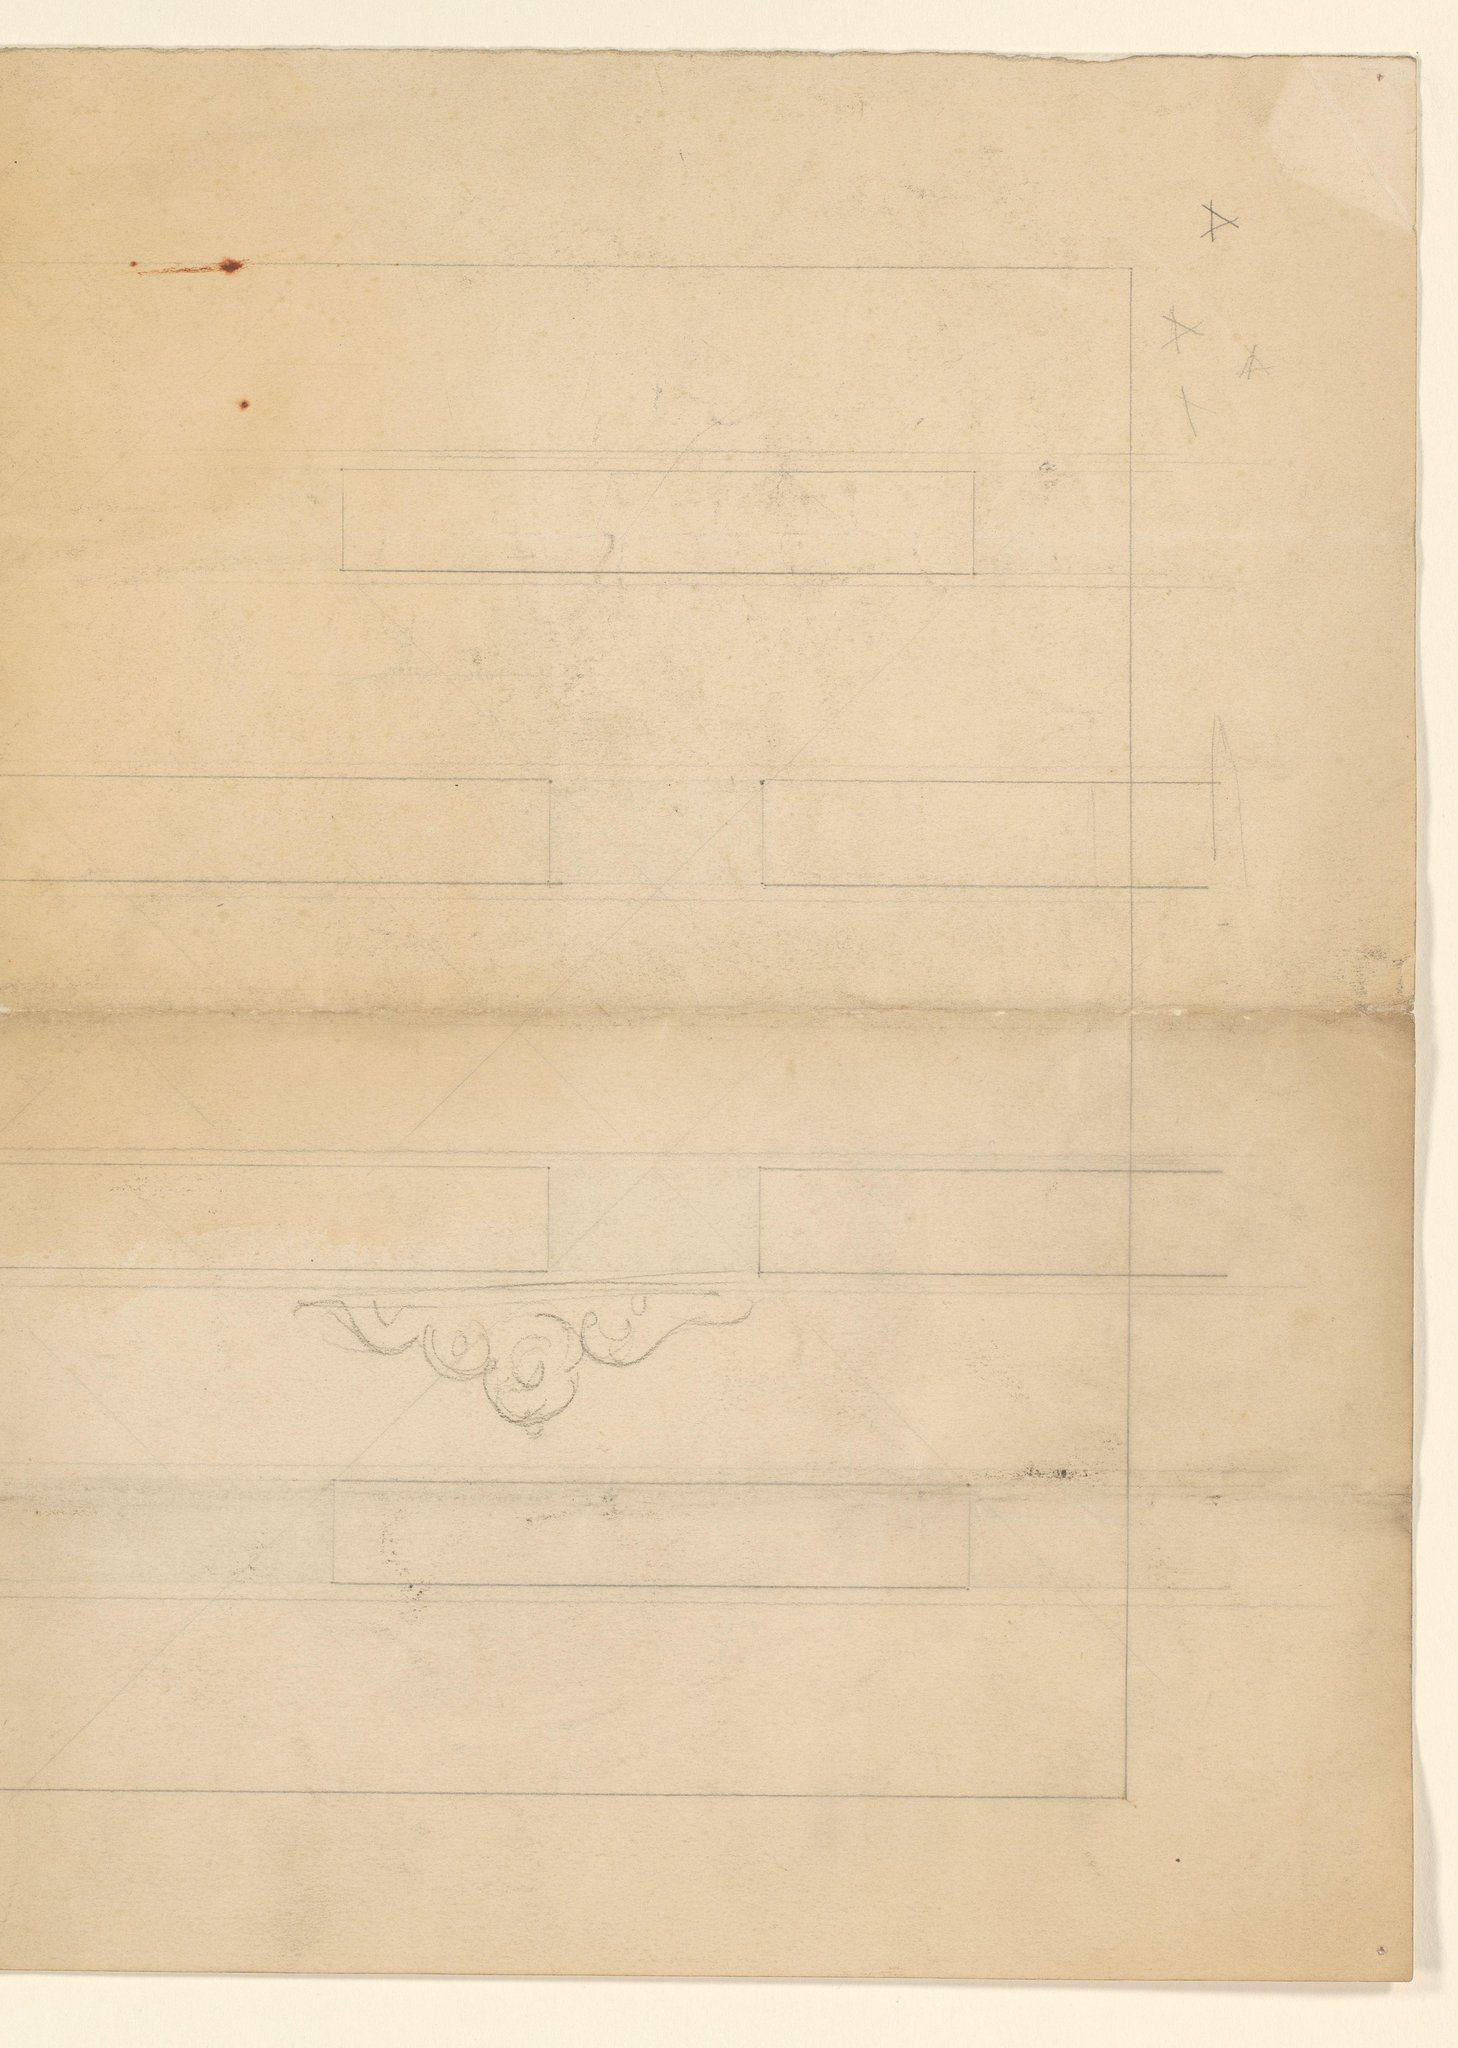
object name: design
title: Ontwerp voor een album voor A.W. Sijthoff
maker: reinier willem petrus de vries (1874-1953)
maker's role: draughtsman, print maker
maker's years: 1874-1953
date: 1901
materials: paper, pencil, watercolor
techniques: brush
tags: magic mathematical figures; magic numbers, words, monograms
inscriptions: collector's mark: ‘R:MVS.’, annotation: ‘[...]’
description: Ontwerp voor een album voor A.W. Sijthoff ter gelegenheid van zijn vijftigjarige uitgeversloopbaan.